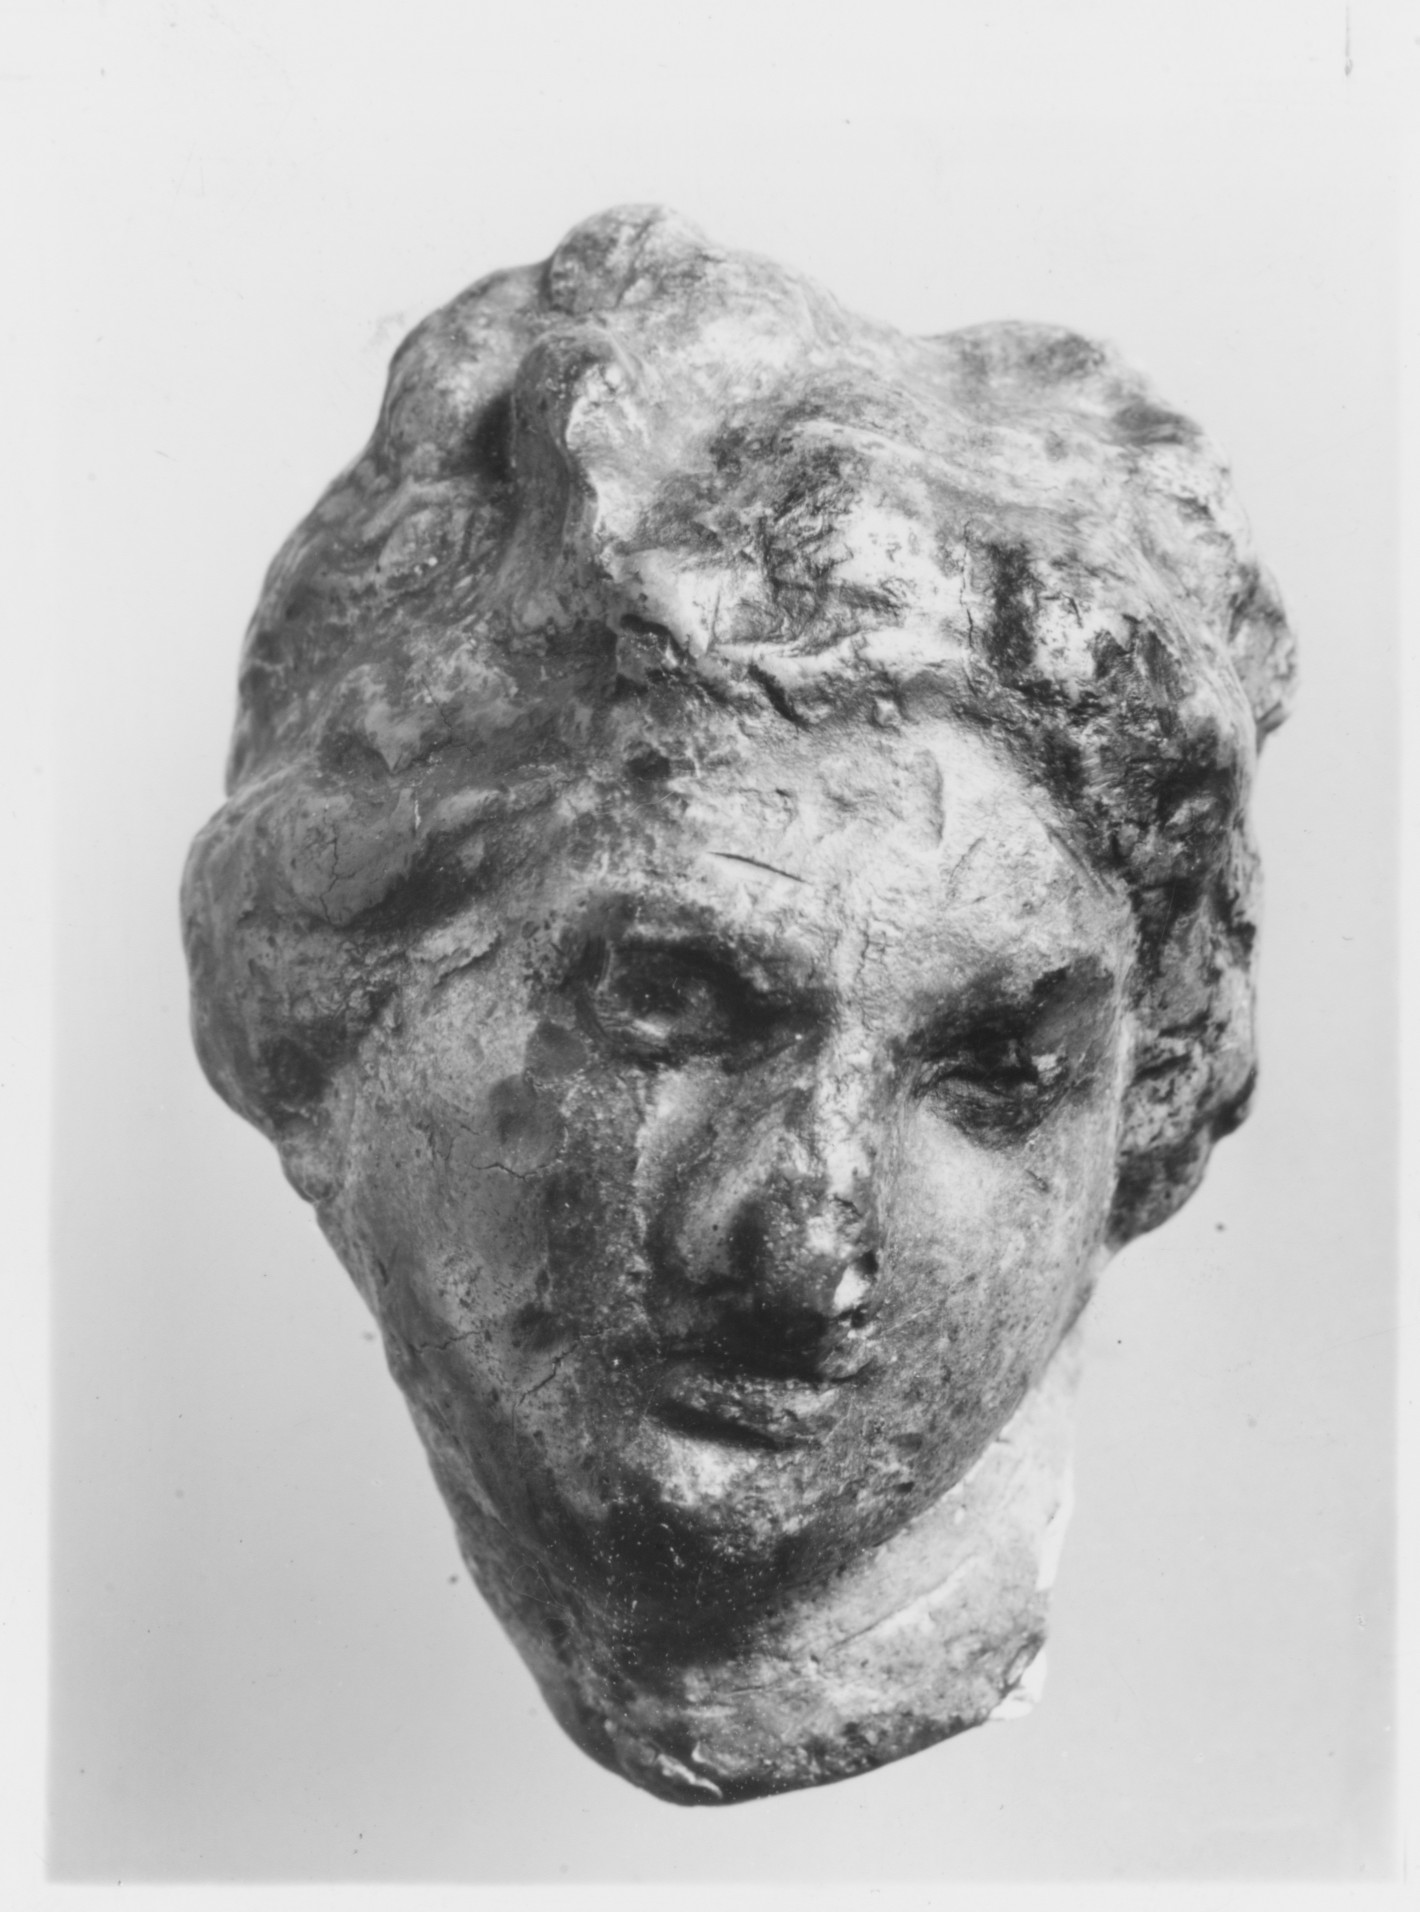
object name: head of aphrodite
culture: egyptian or greek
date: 146-30 BCE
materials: paint, wax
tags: heads,aphrodite